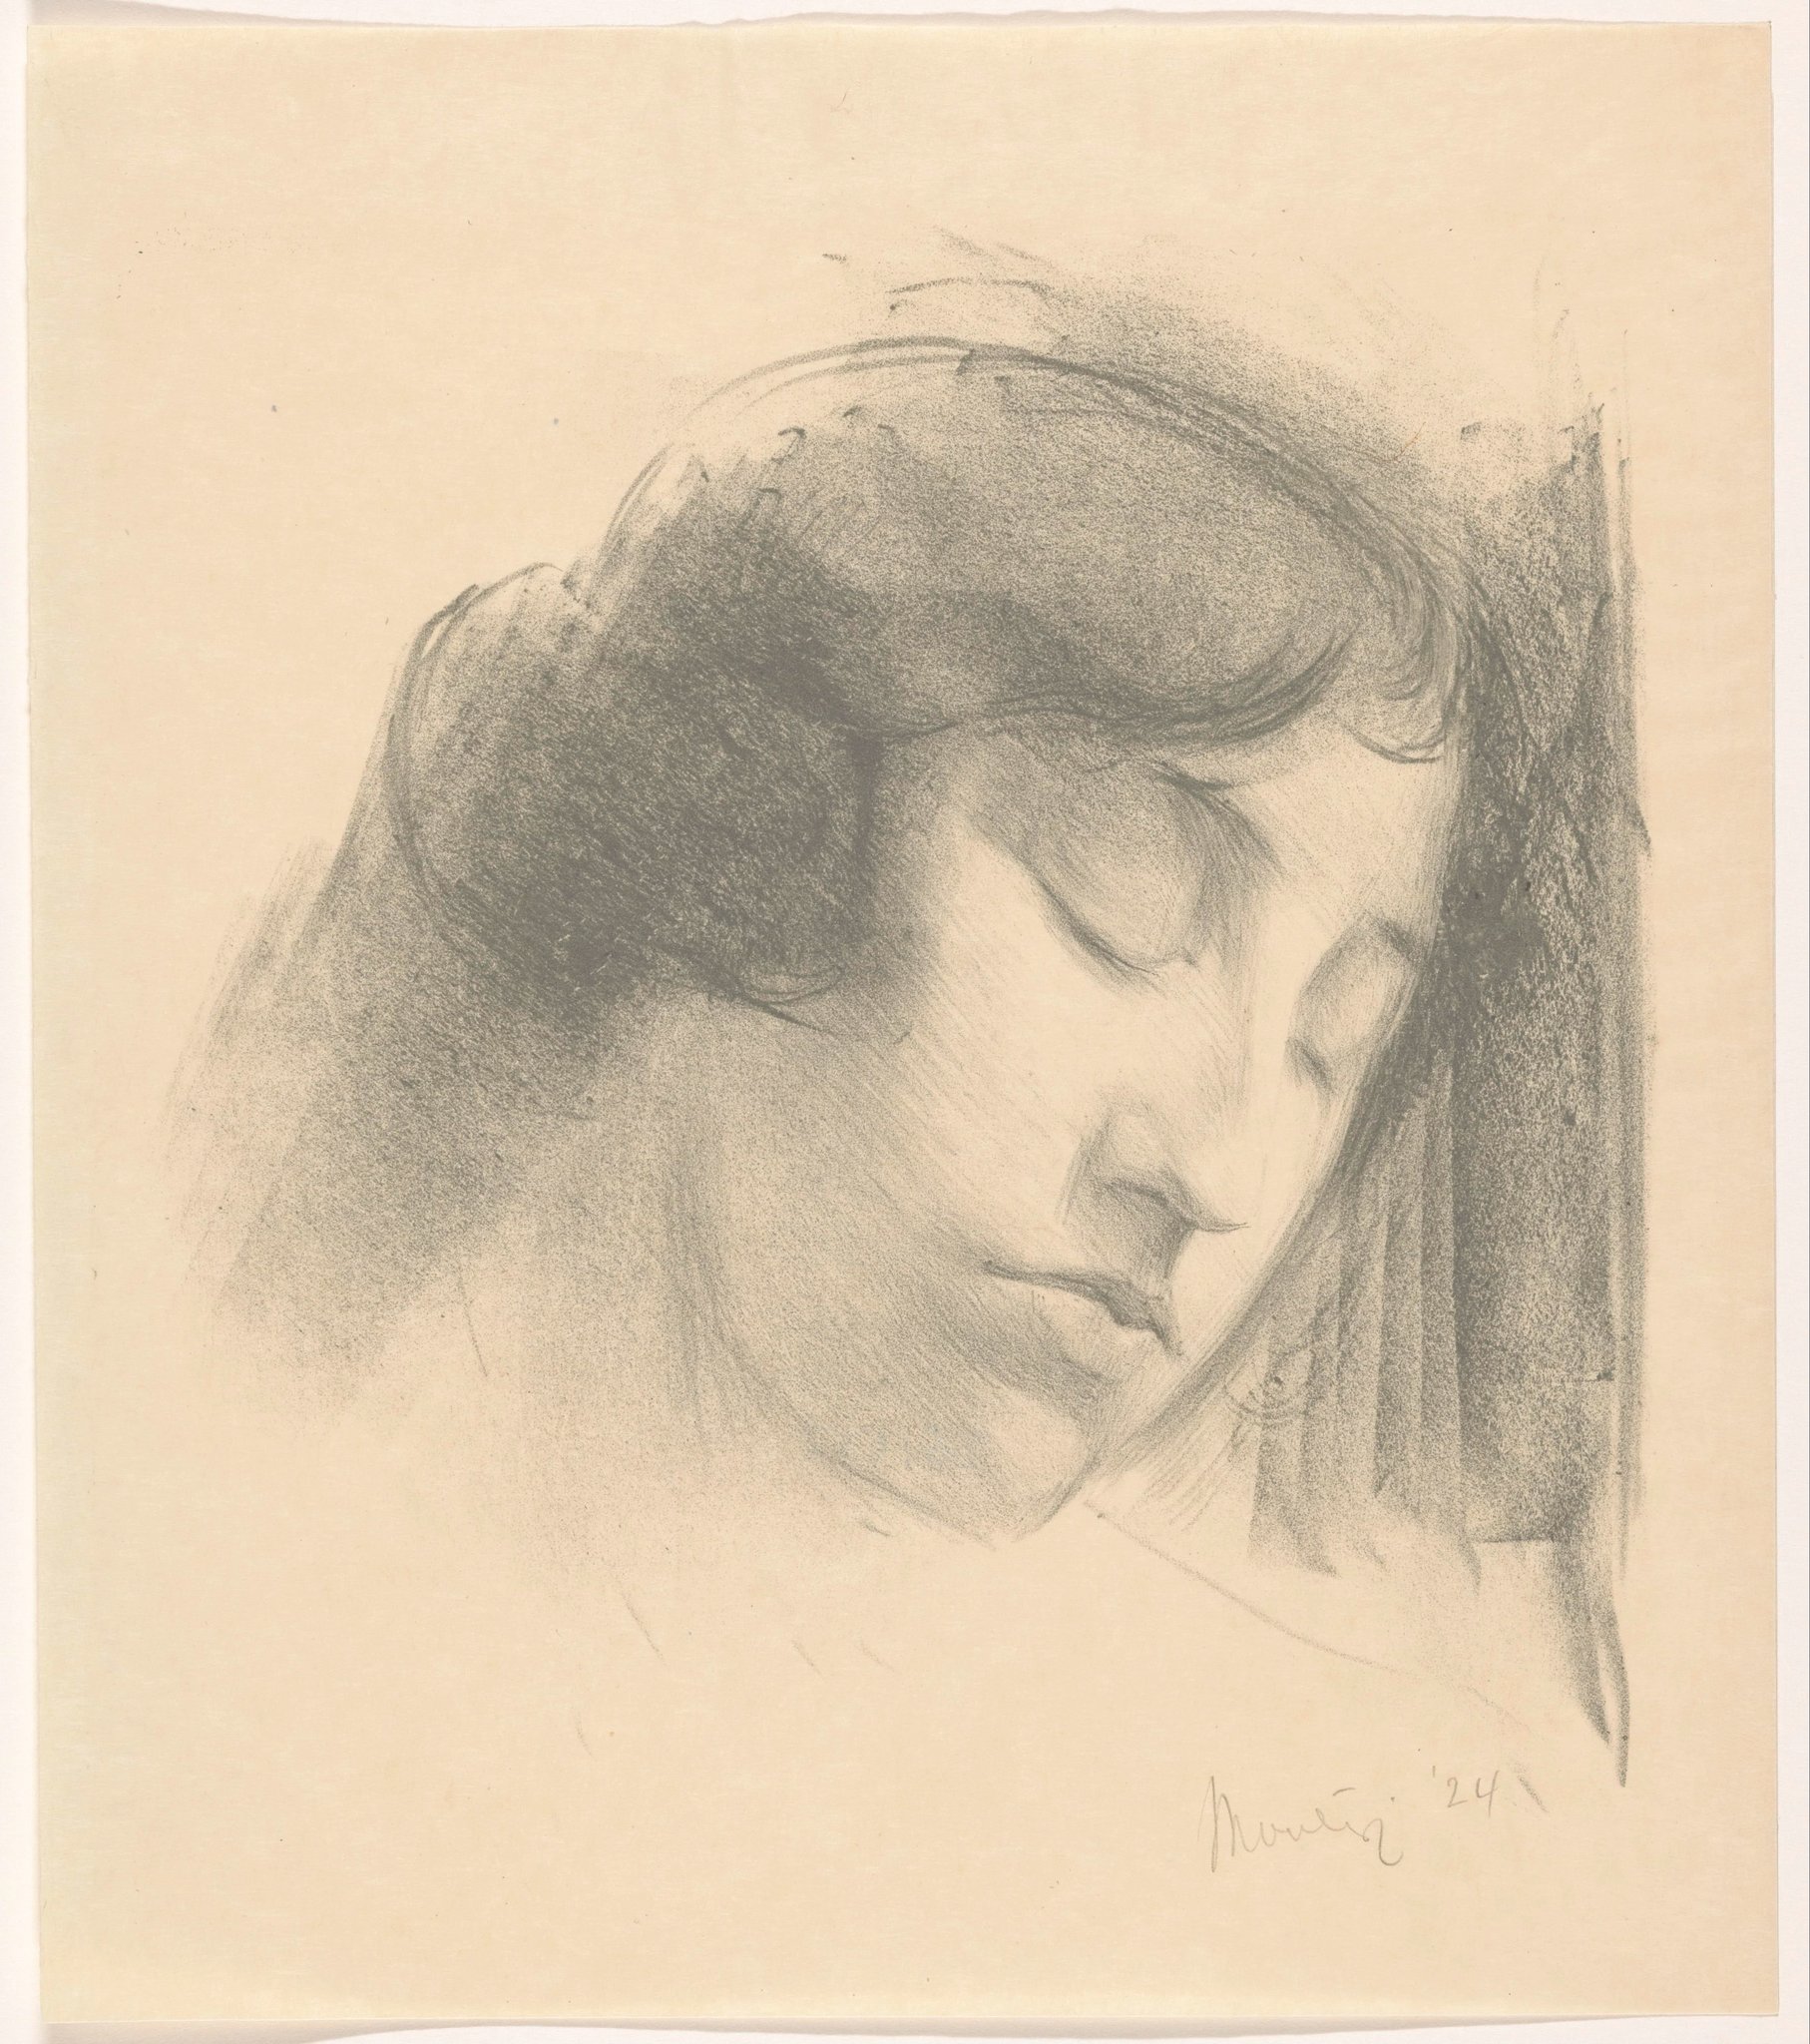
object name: print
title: Hoofd van een vrouw met gesloten ogen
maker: simon moulijn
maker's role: draughtsman, print maker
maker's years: 1866-1948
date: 1924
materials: paper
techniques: lithograph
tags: adult woman, eyes closed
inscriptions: collector's mark: Lugt 2228